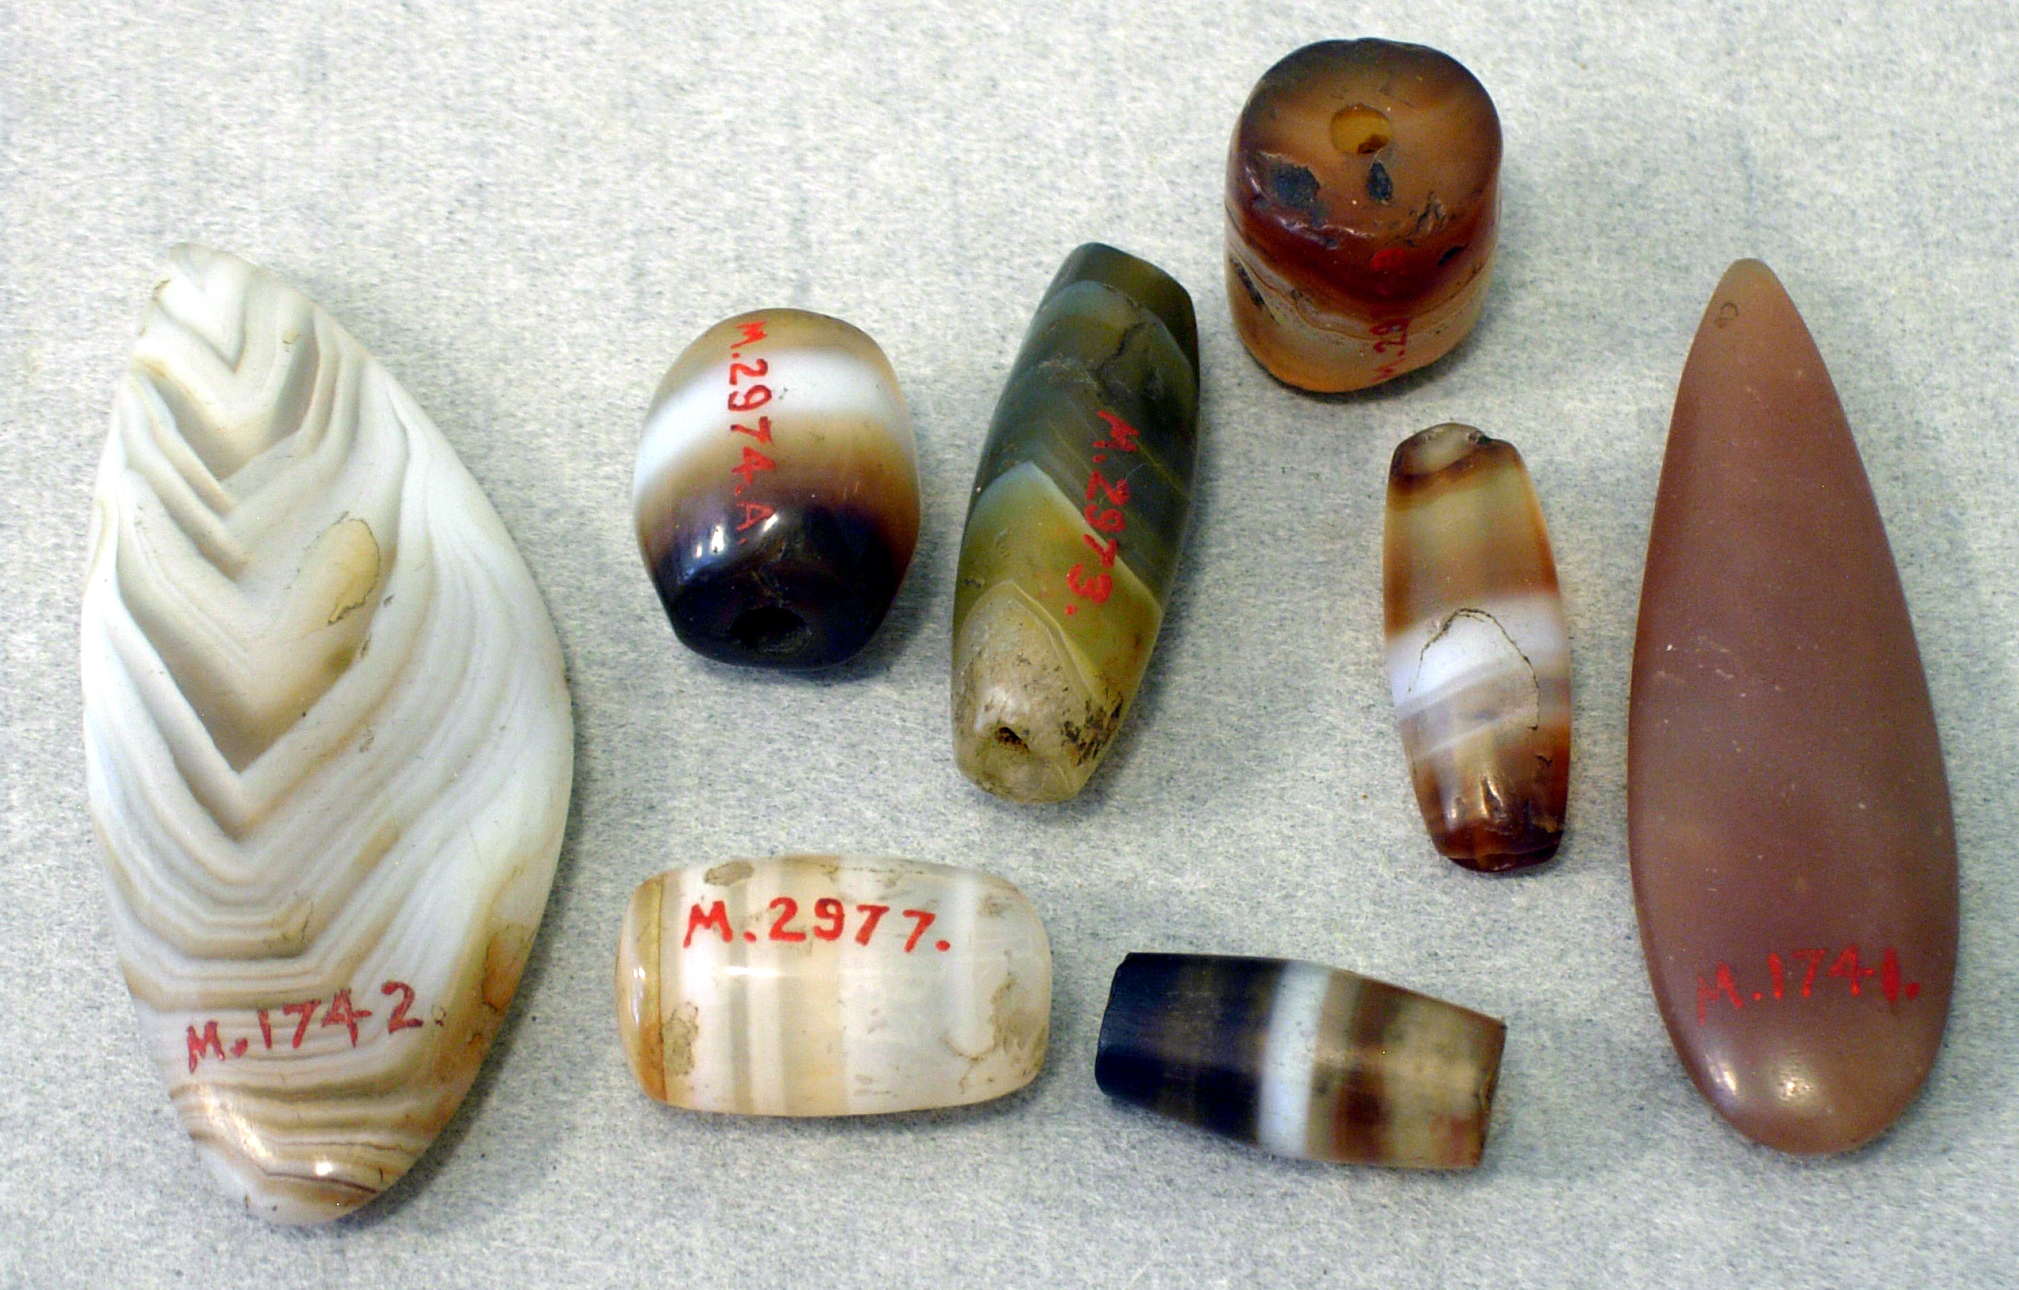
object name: bead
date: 801-1900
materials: stone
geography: egypt